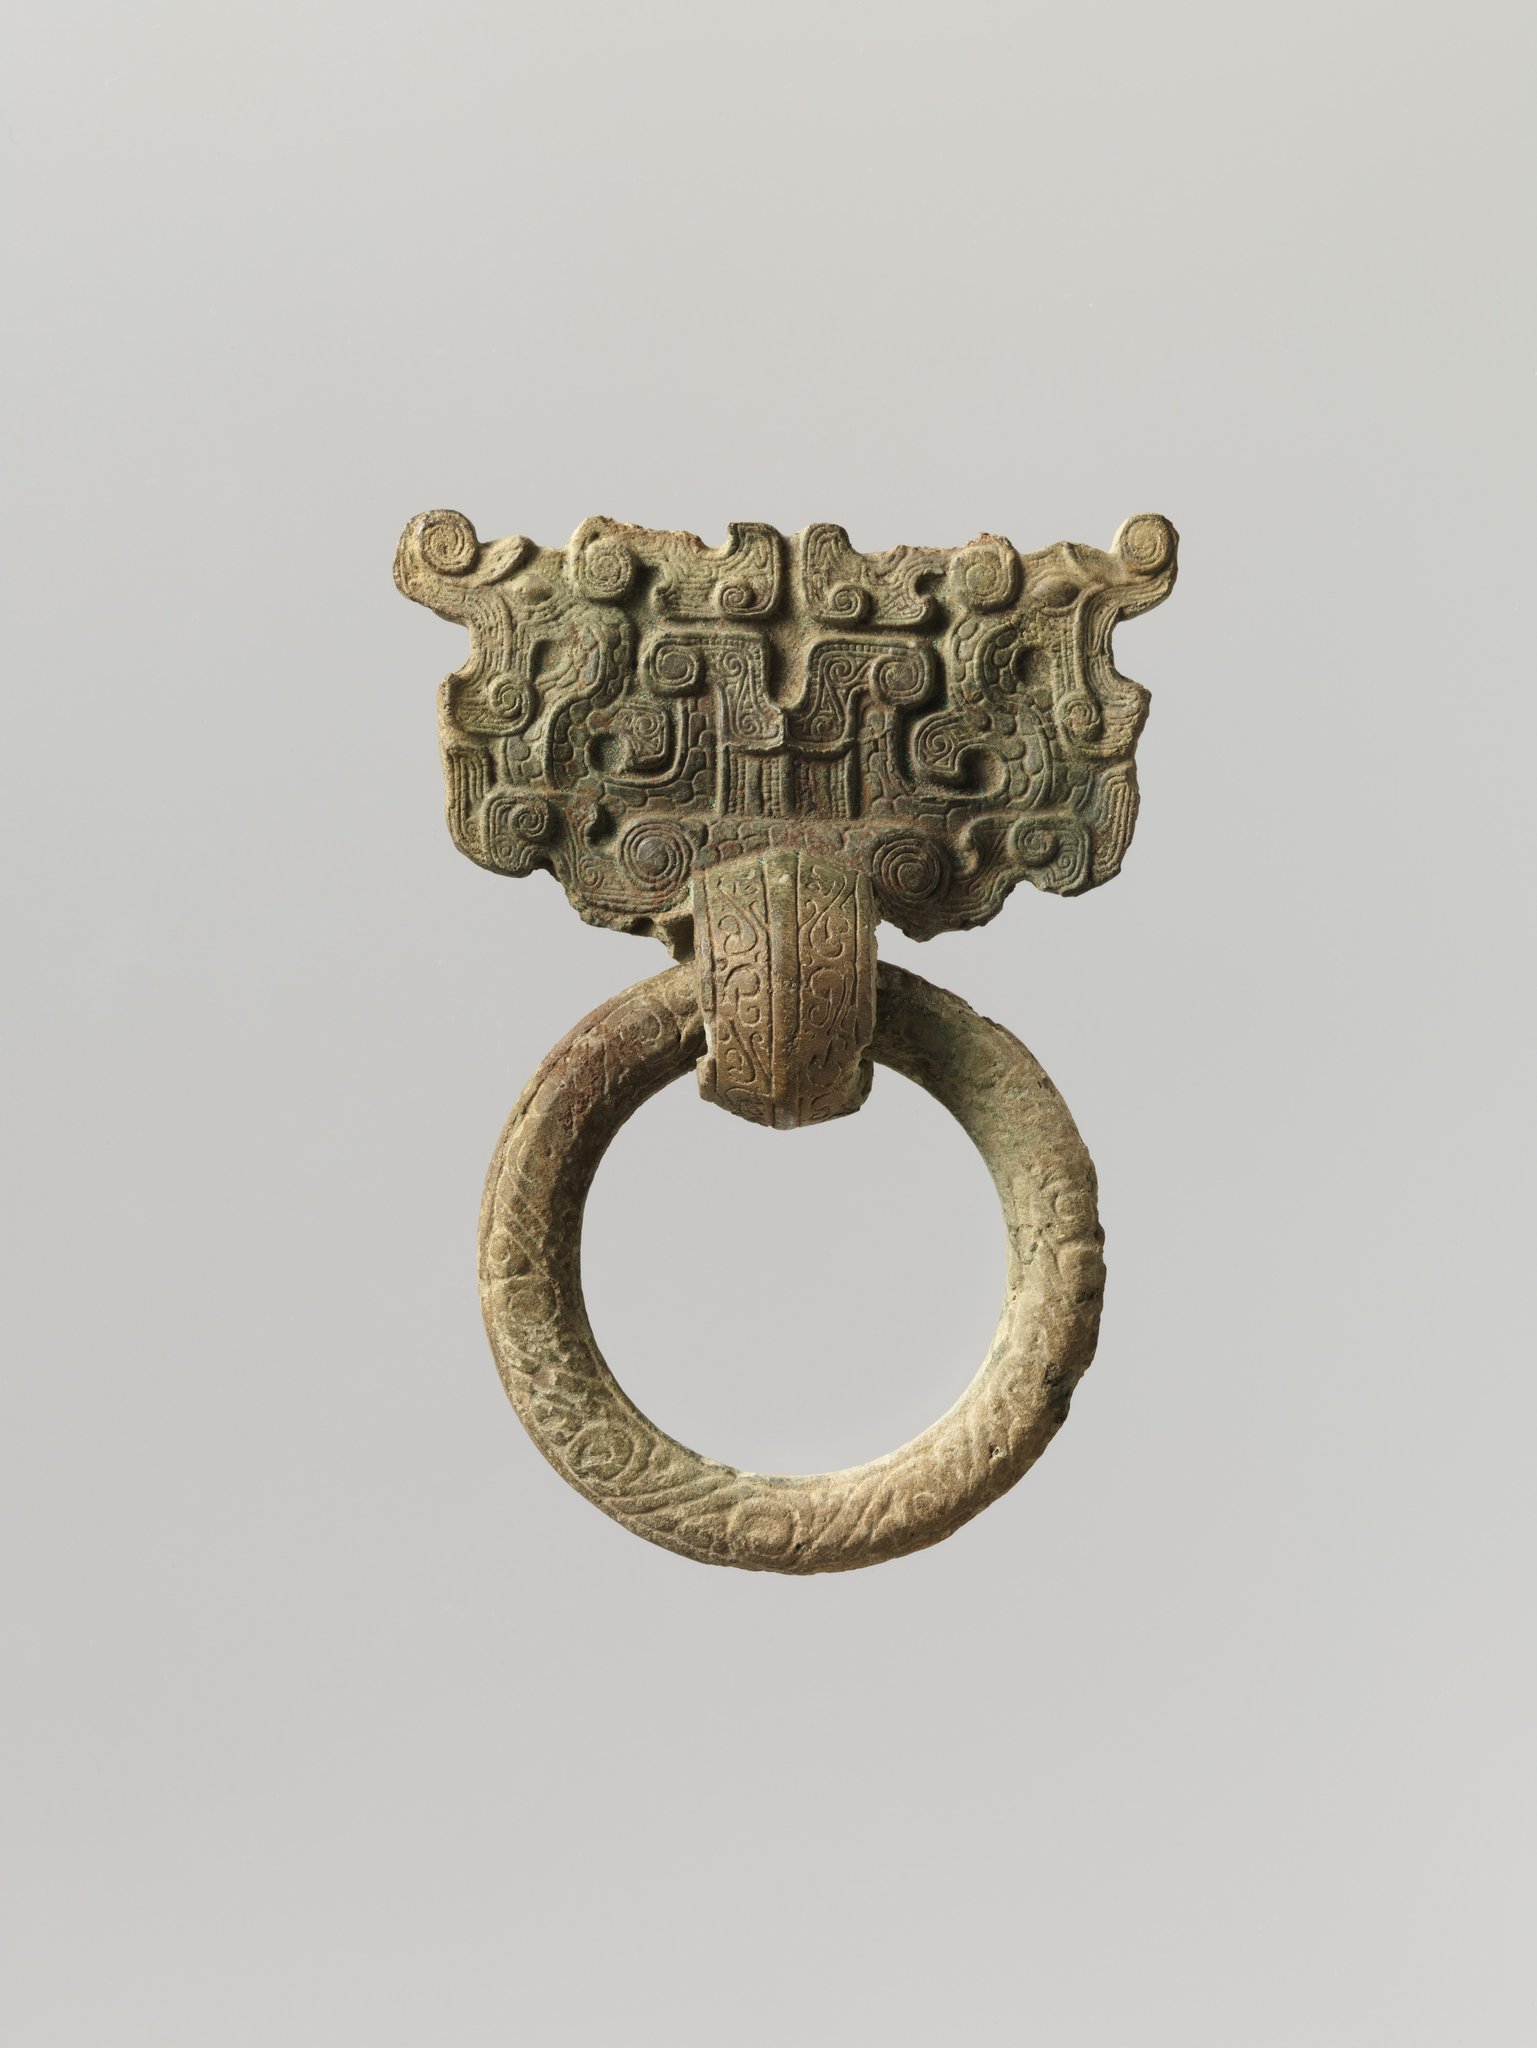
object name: ring handle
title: Ring Handle with Mask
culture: chinese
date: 1046-771 BCE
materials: bronze